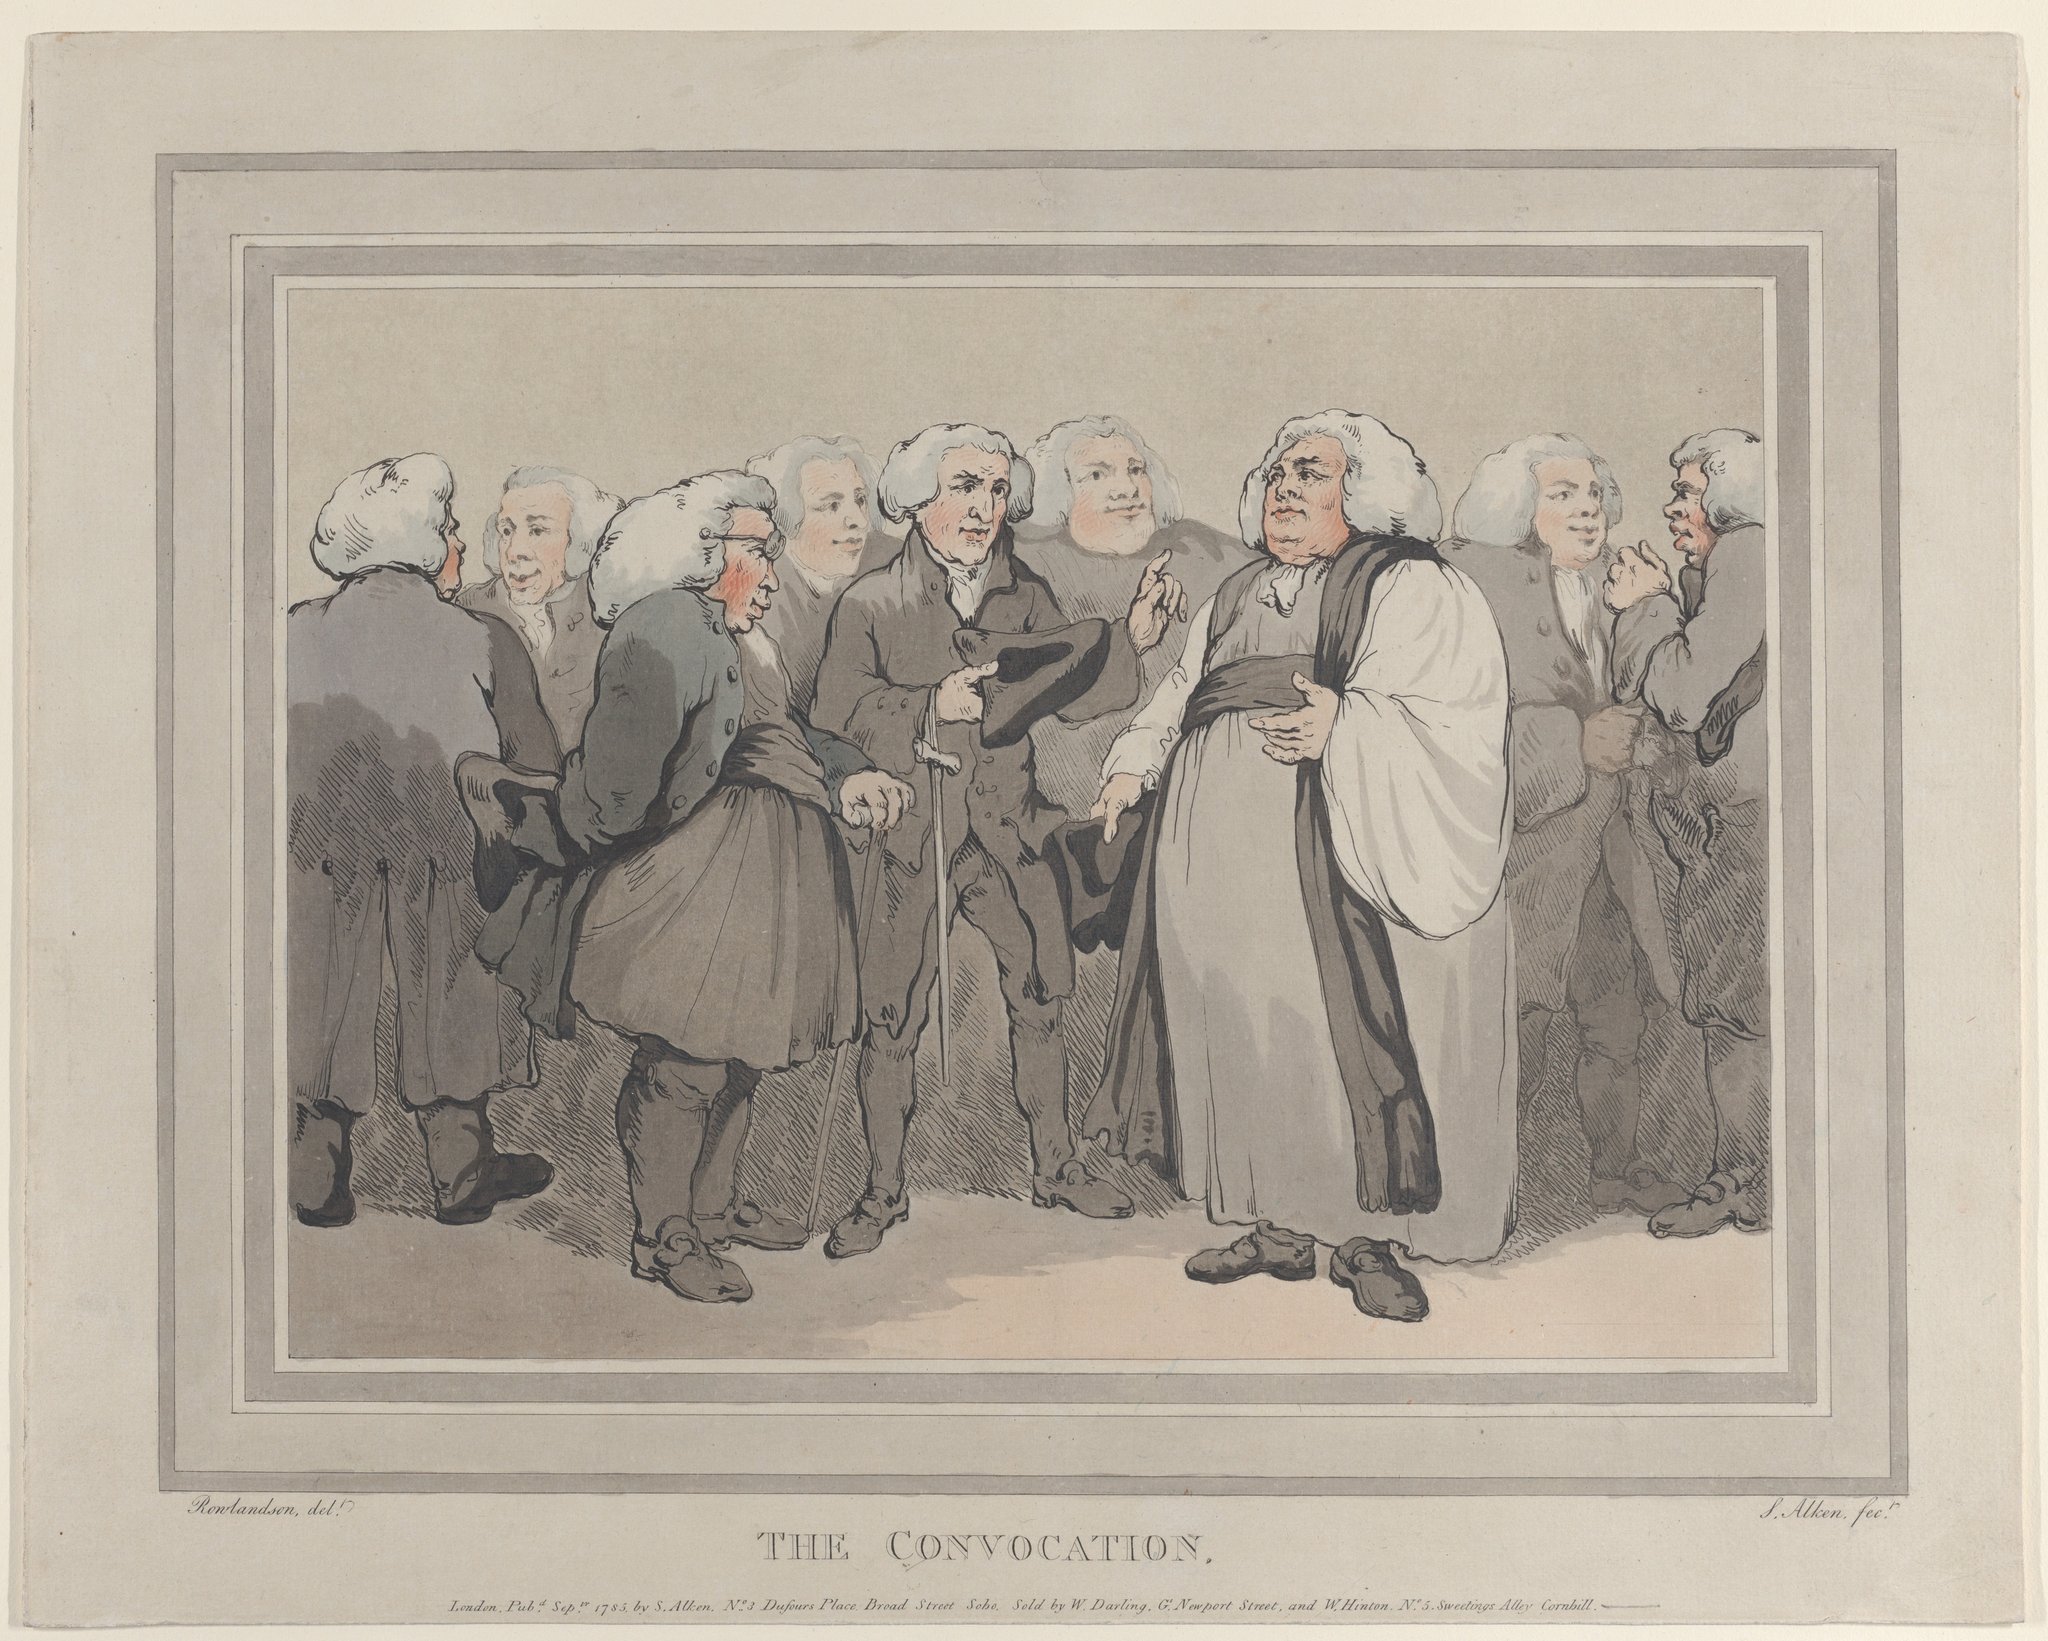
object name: print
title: The Convocation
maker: thomas rowlandson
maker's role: artist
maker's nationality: british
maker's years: 1757-1827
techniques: etching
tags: men